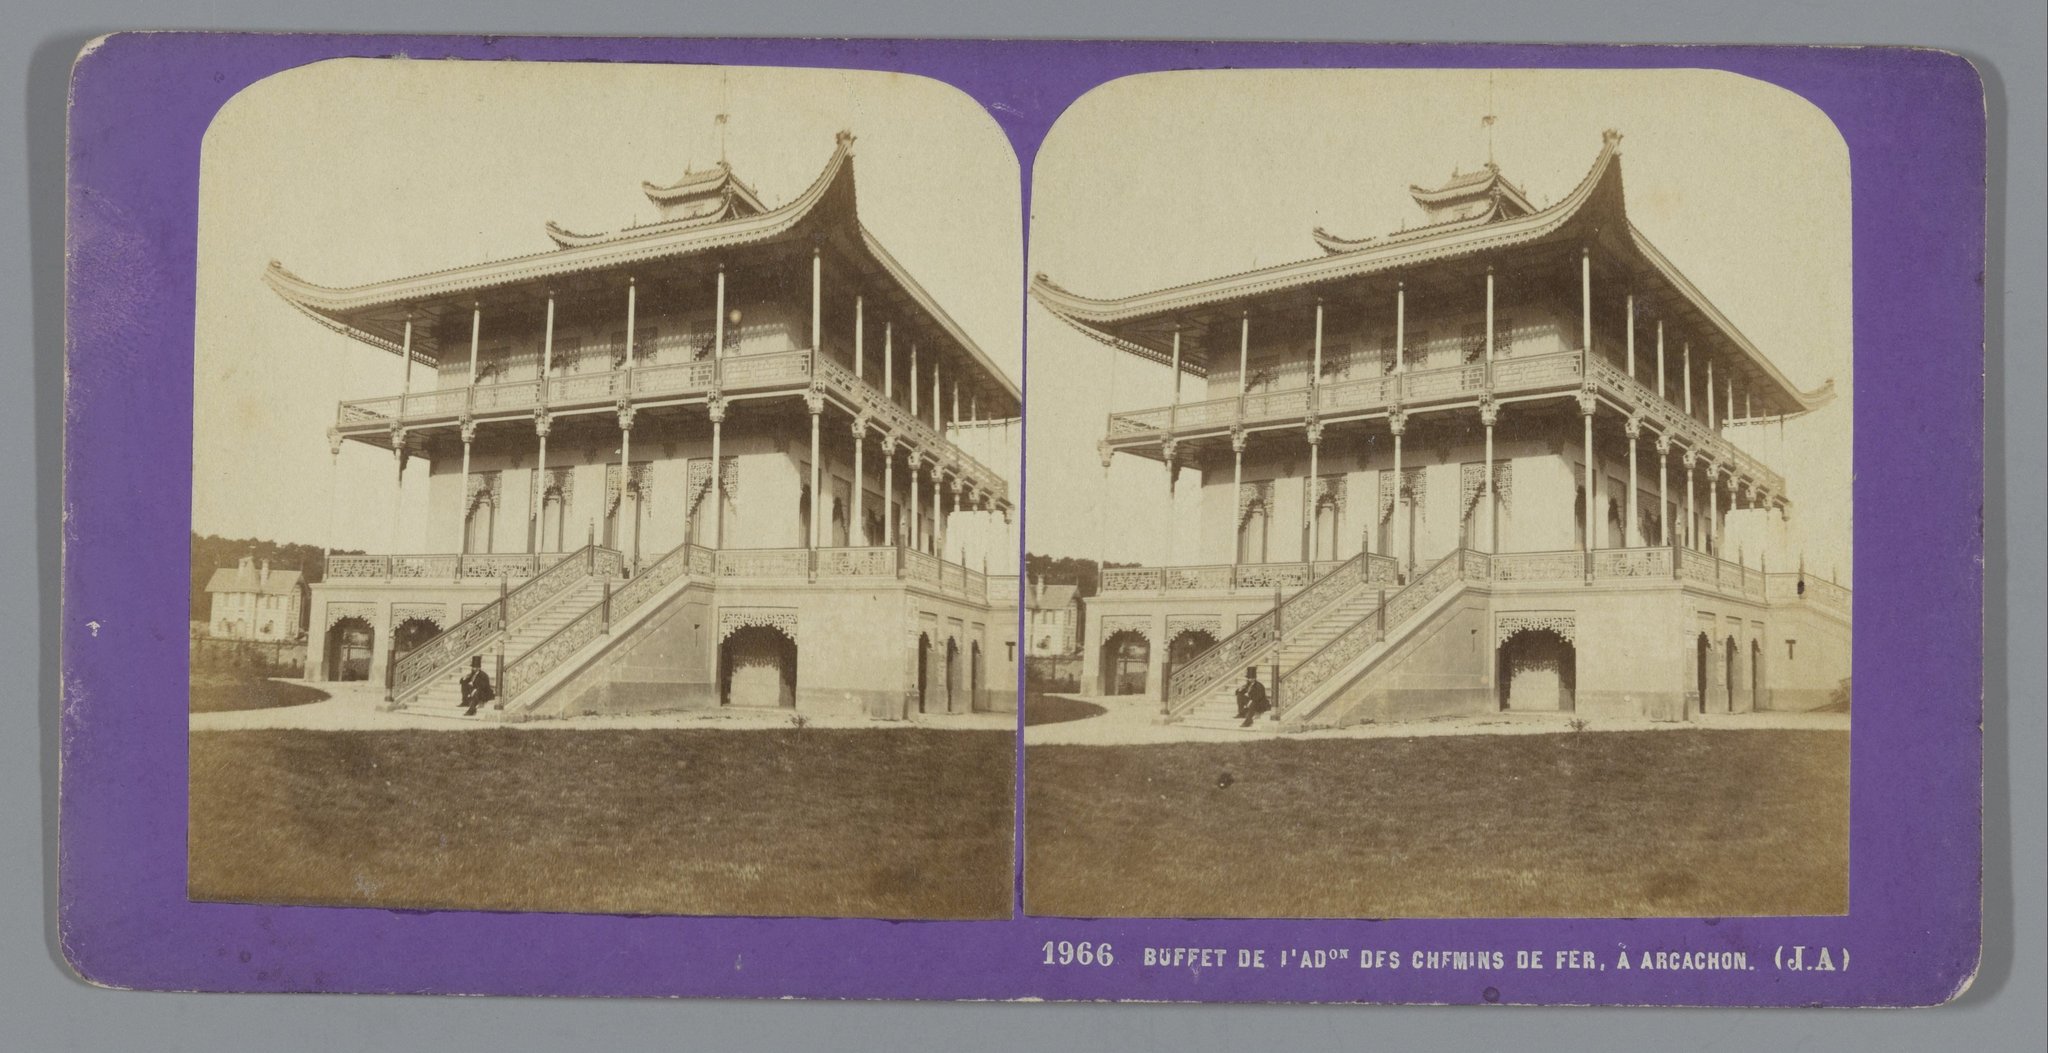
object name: stereograph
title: Buffet de l'Adon des Chemins de fer, a Arcachon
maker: jean andrieu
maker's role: fotograaf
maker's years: 1816-1872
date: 1862-1876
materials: cardboard, photographic support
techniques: albumen print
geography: arcachon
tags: arcachon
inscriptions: number: ‘1966’